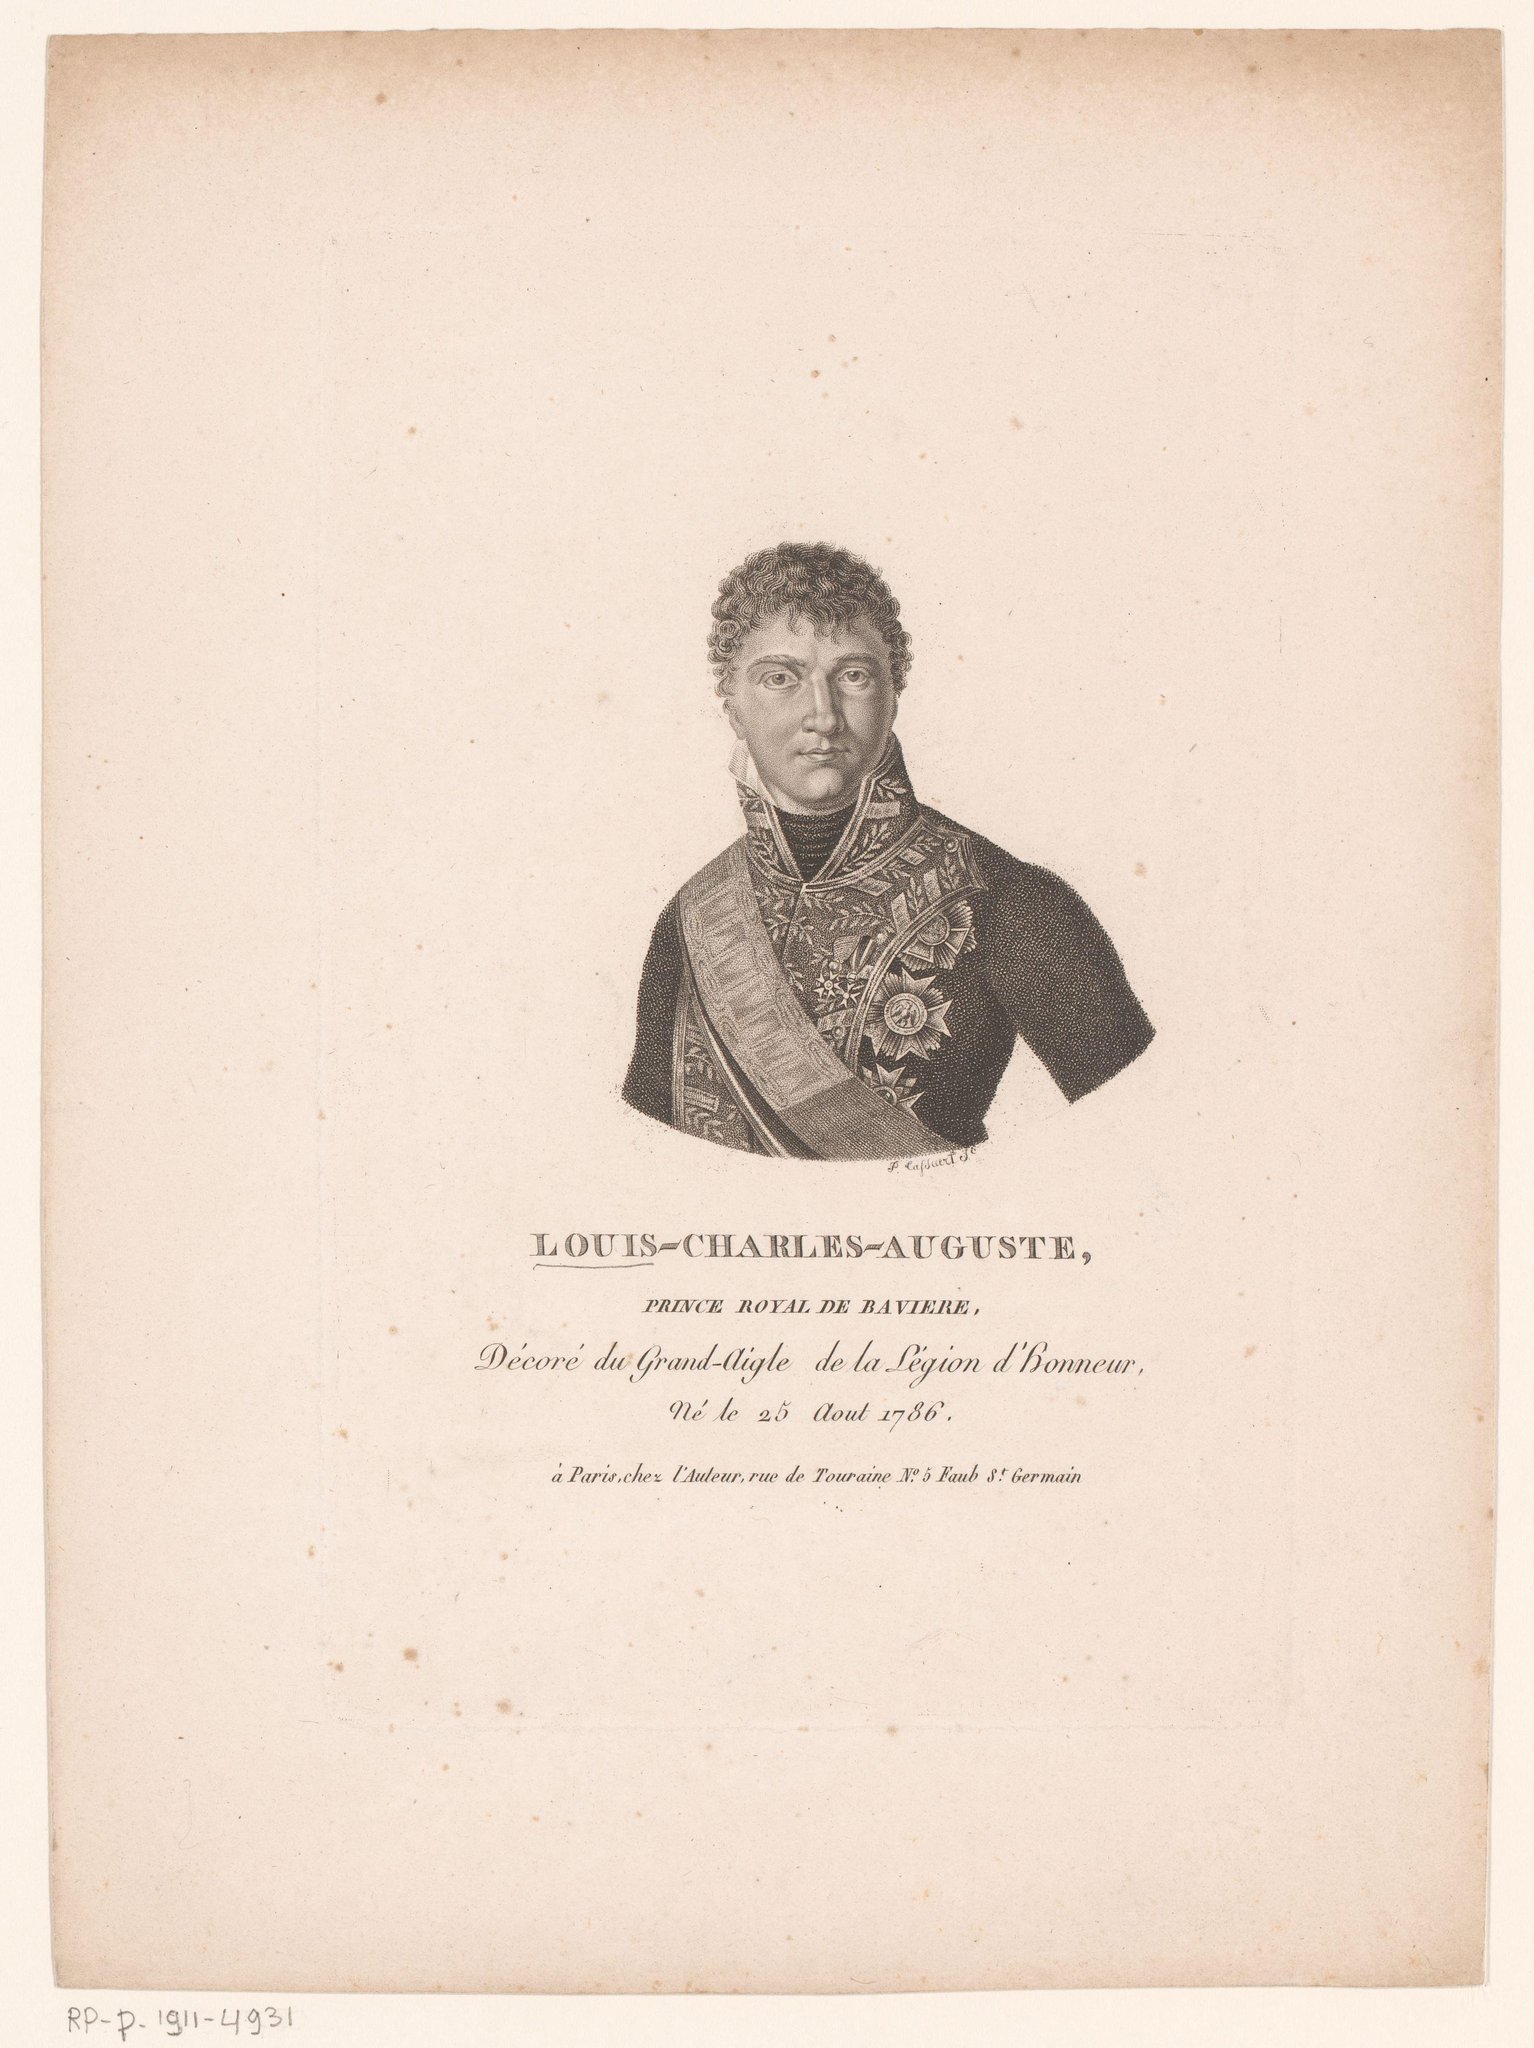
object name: print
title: Portret van koning Lodewijk I van Beieren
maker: paul tassaert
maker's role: print maker, publisher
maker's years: -1855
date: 1775-1855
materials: paper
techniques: engraving, etching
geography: paris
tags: lodewijk i (koning van beieren), historical persons, king, crown prince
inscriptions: collector's mark: Lugt 2228